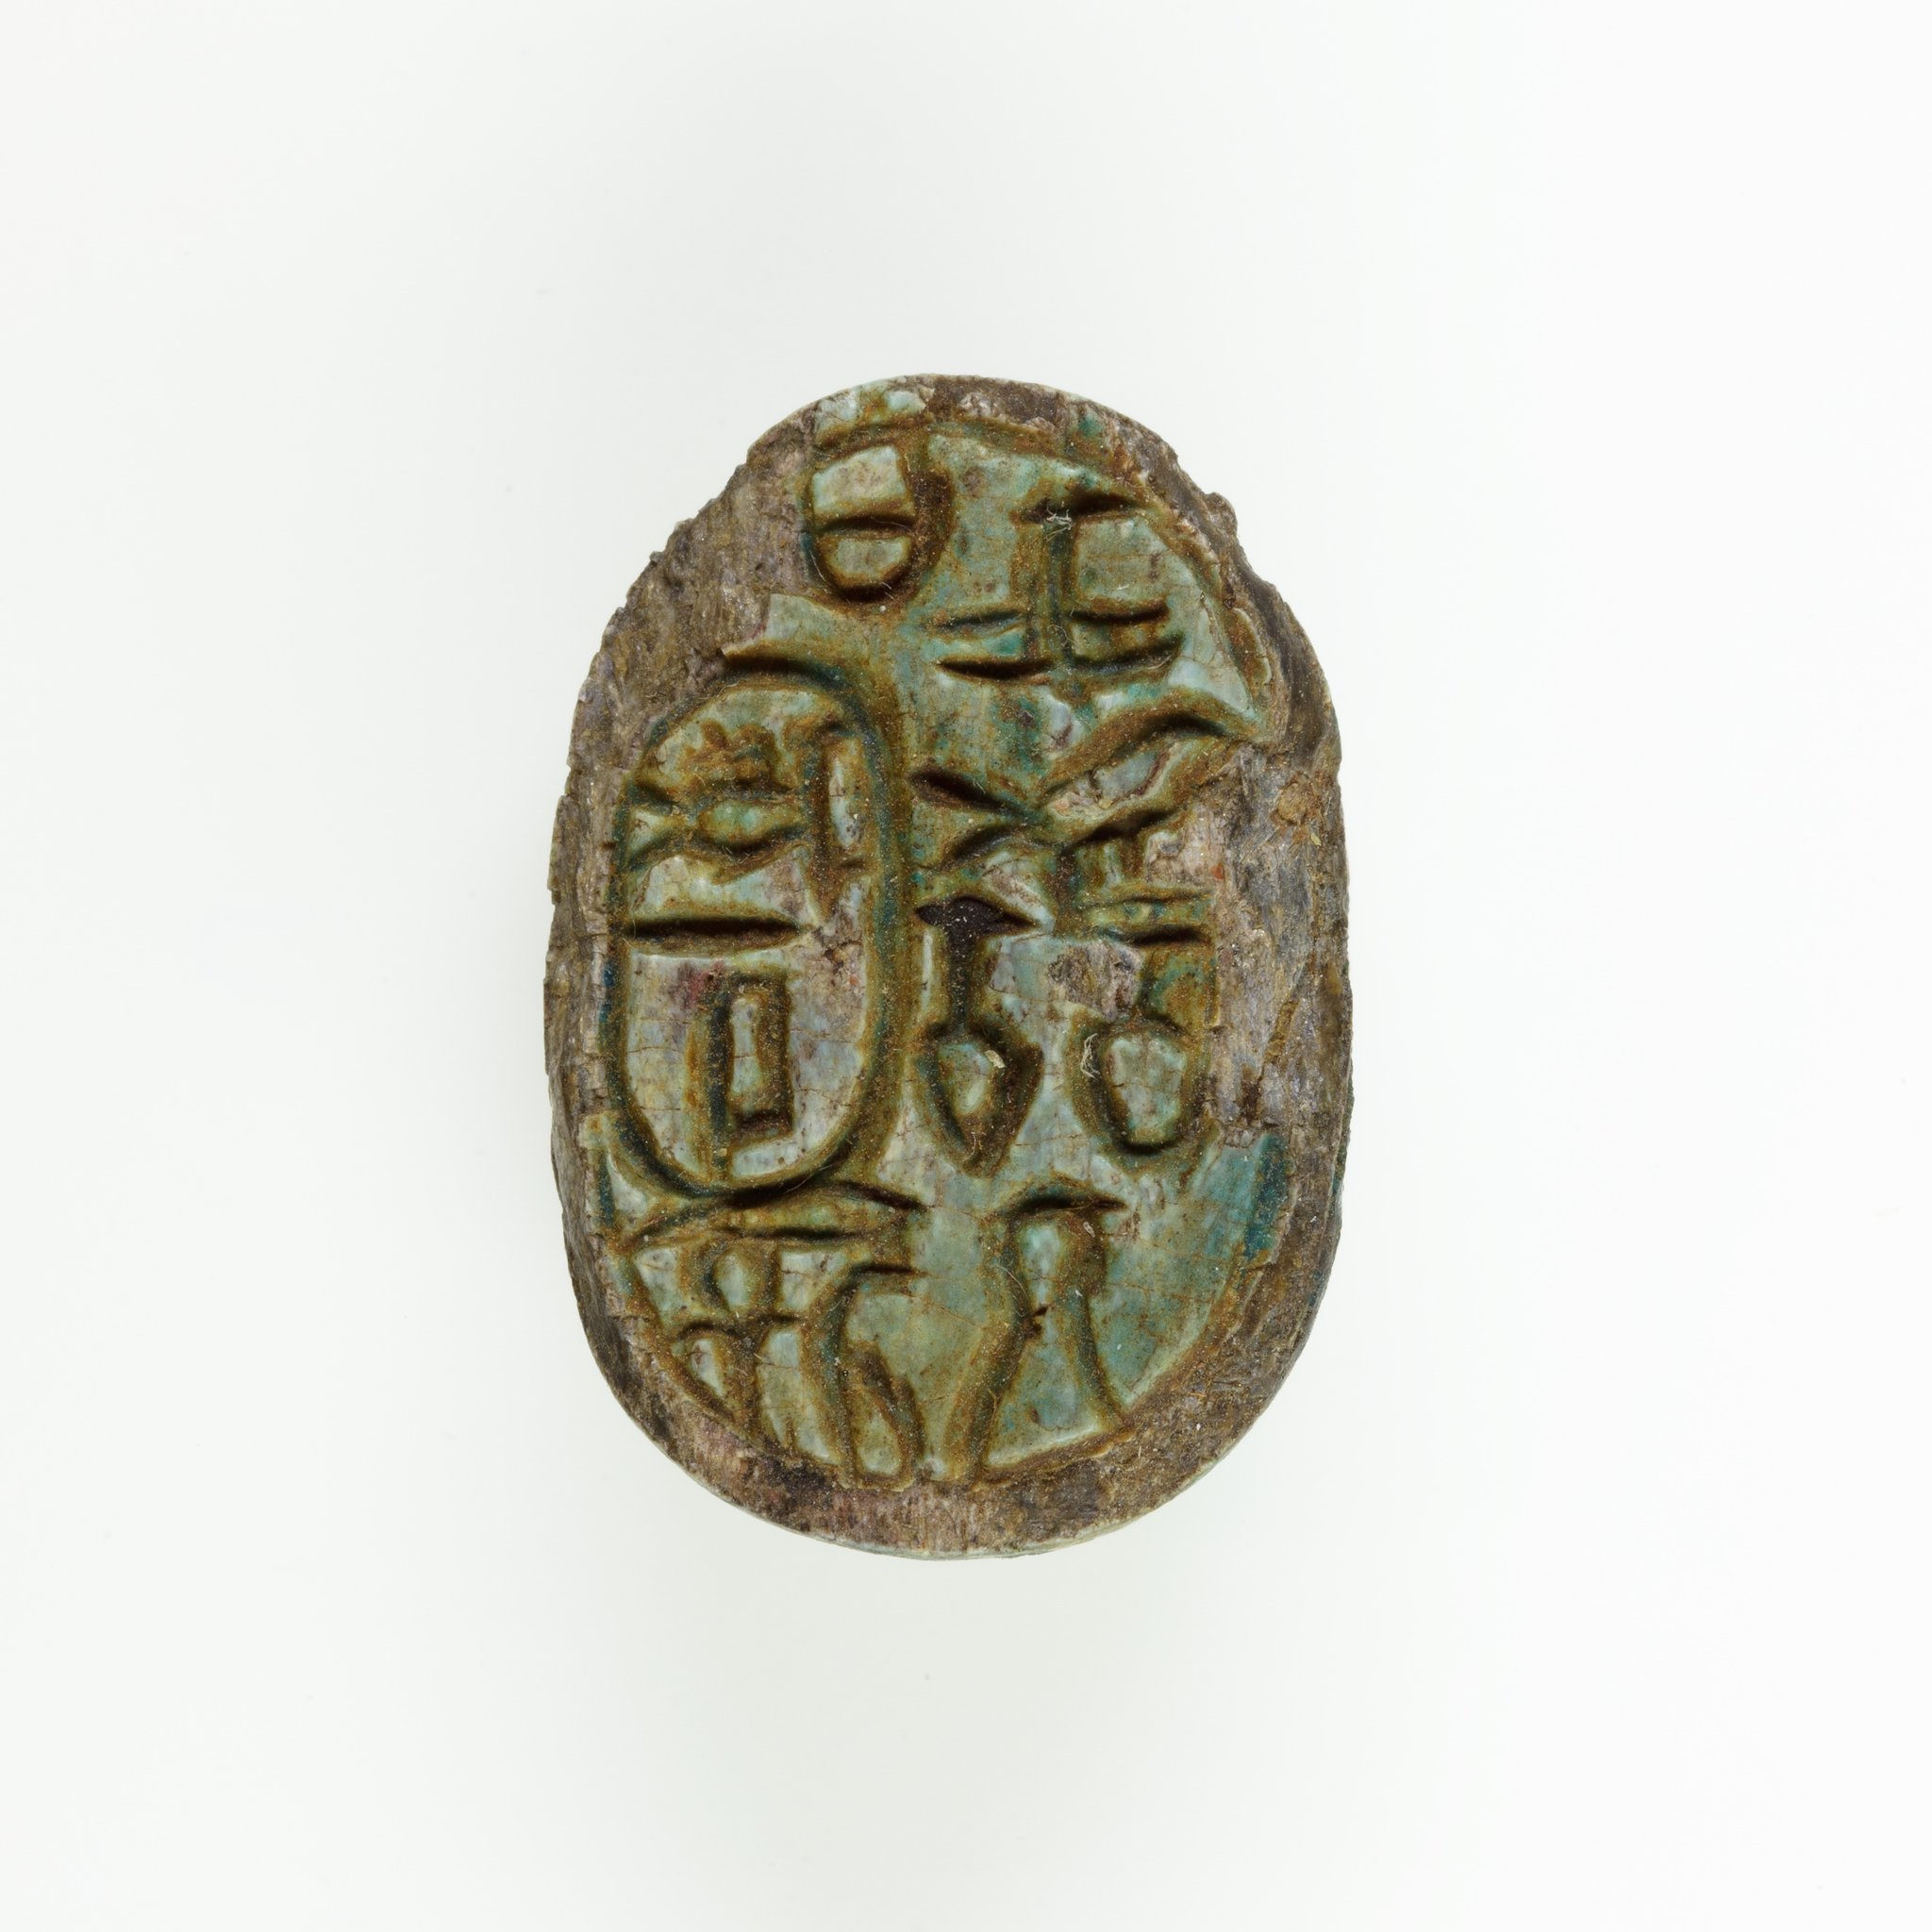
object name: scarab, queen inni, cartouche, royal title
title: Scarab of Queen Inni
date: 1700-1676 BCE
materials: stone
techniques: glazing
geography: egypt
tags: hieroglyphs,scarabs